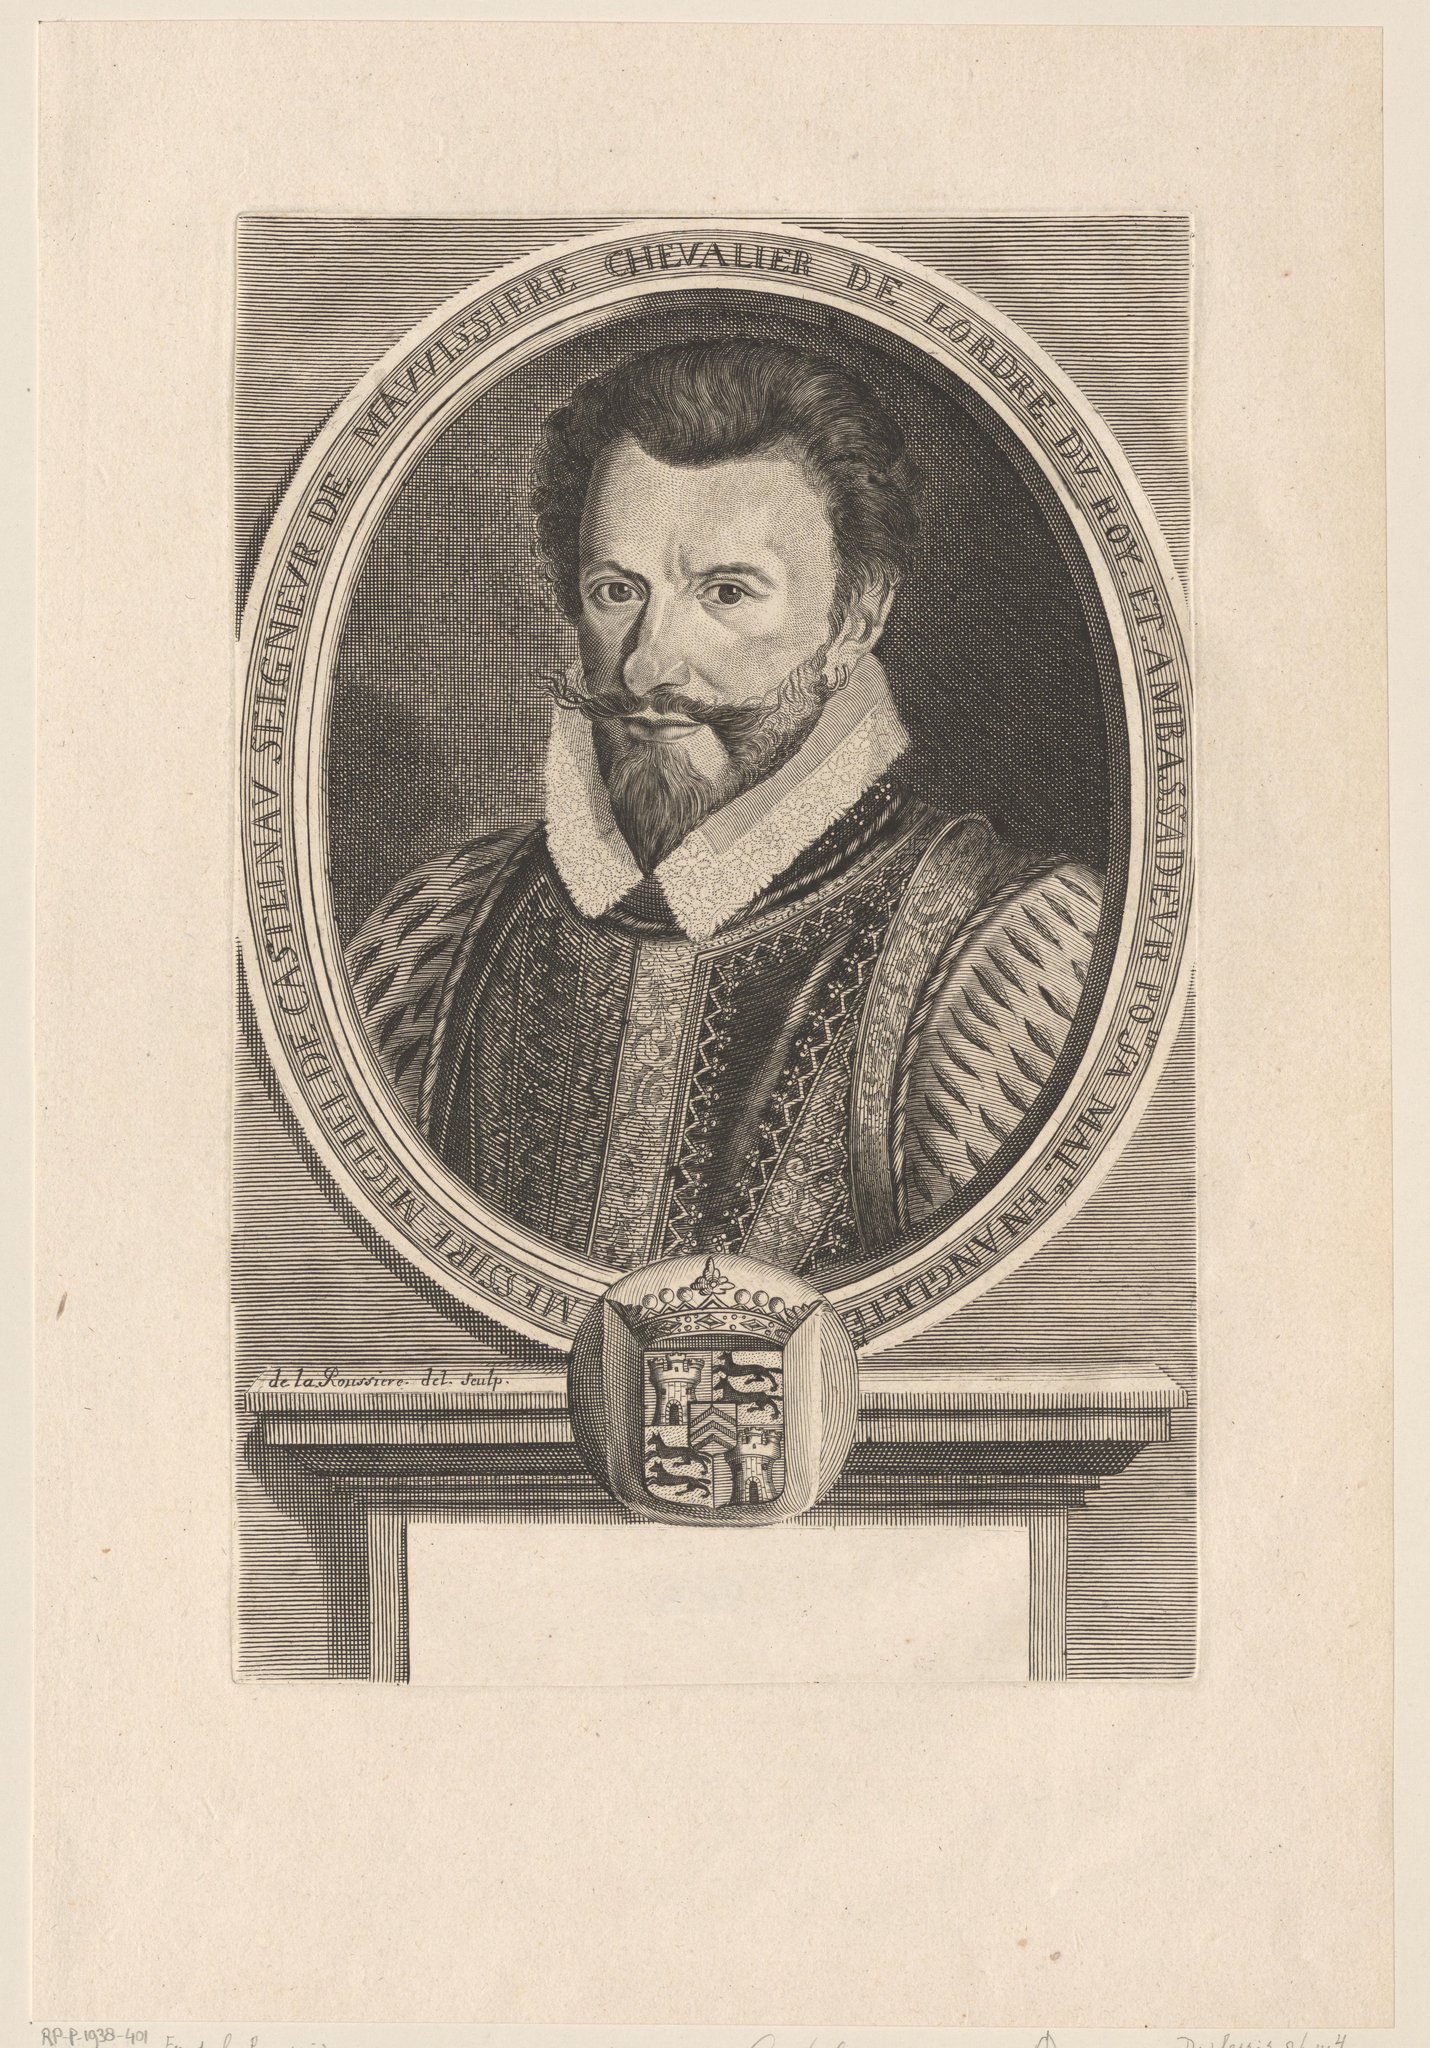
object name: print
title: Portret van Michel de Castelnau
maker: françois de la roussière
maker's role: print maker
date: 1655-1665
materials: paper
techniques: engraving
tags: historical persons, armorial bearing, heraldry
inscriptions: collector's mark: Lugt 2228